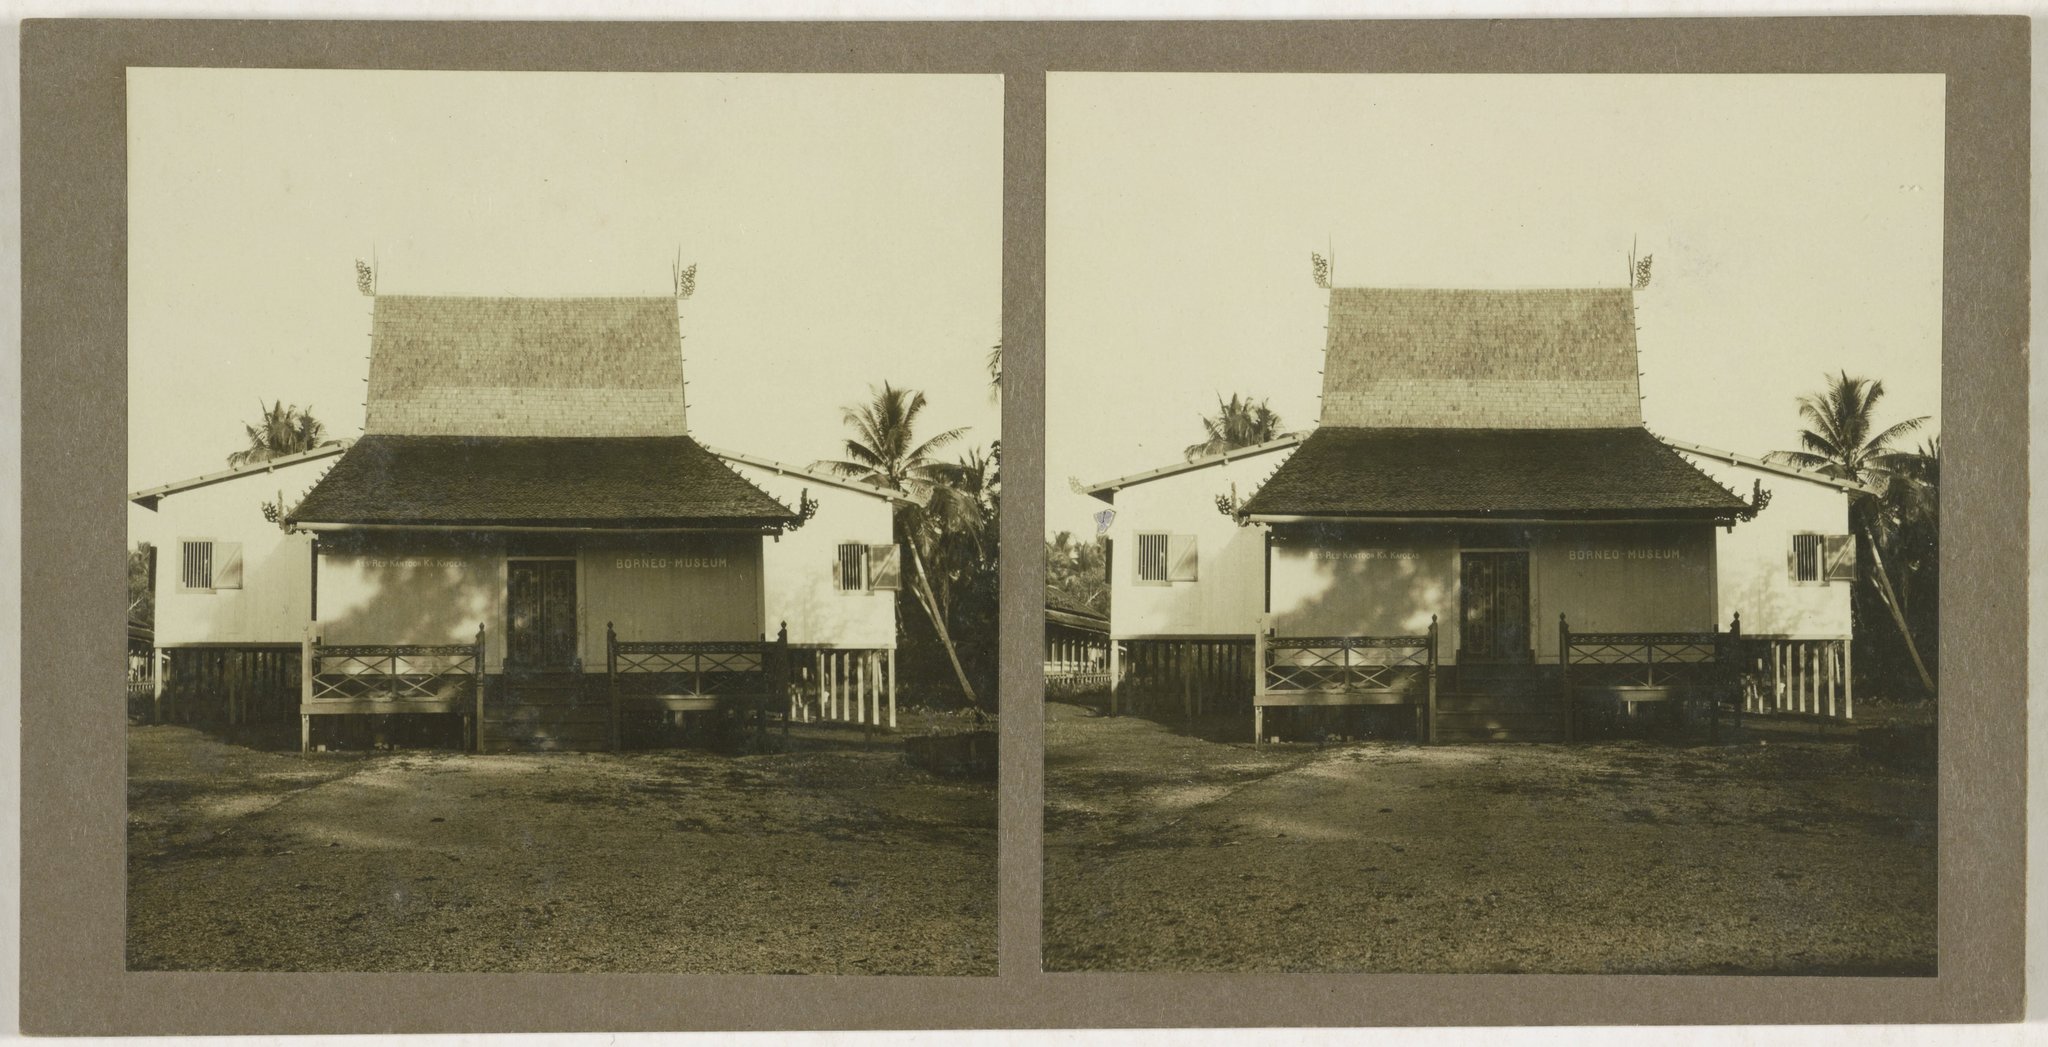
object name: stereograph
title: Borneo-Museum te Banjarmasin, Kalimantan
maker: Anonymous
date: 1907-1940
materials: paper, cardboard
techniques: gelatin silver print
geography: banjarmasin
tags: permanent exhibition, museum